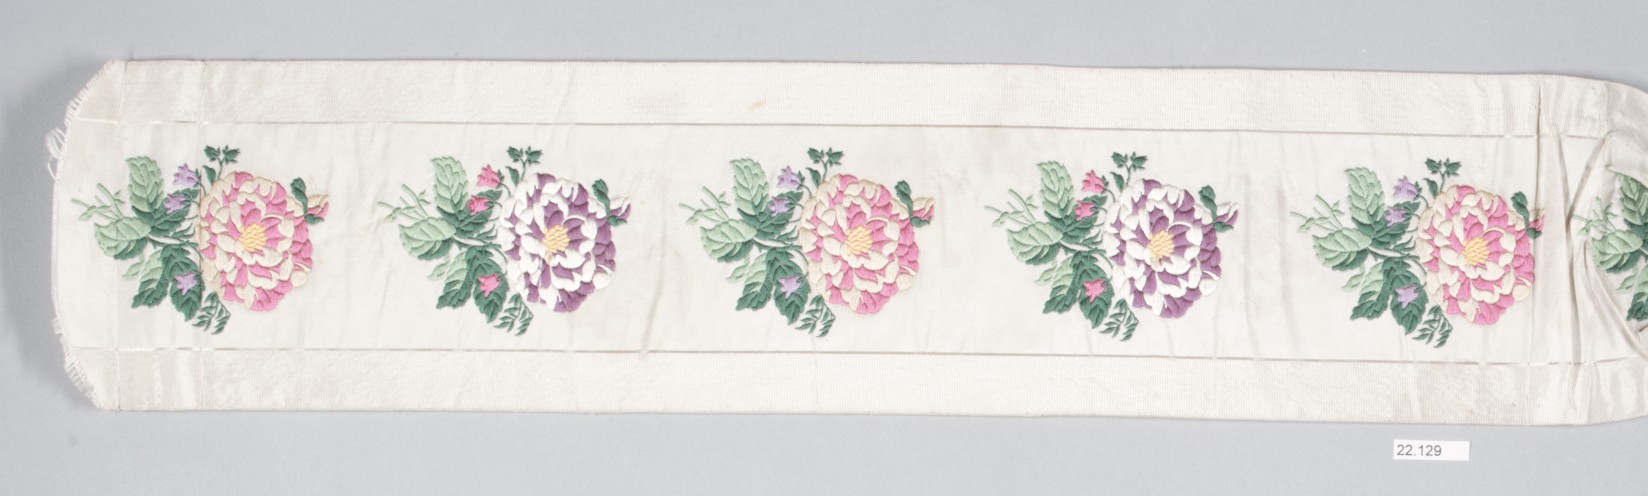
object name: ribbon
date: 1834-1866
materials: silk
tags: flowers